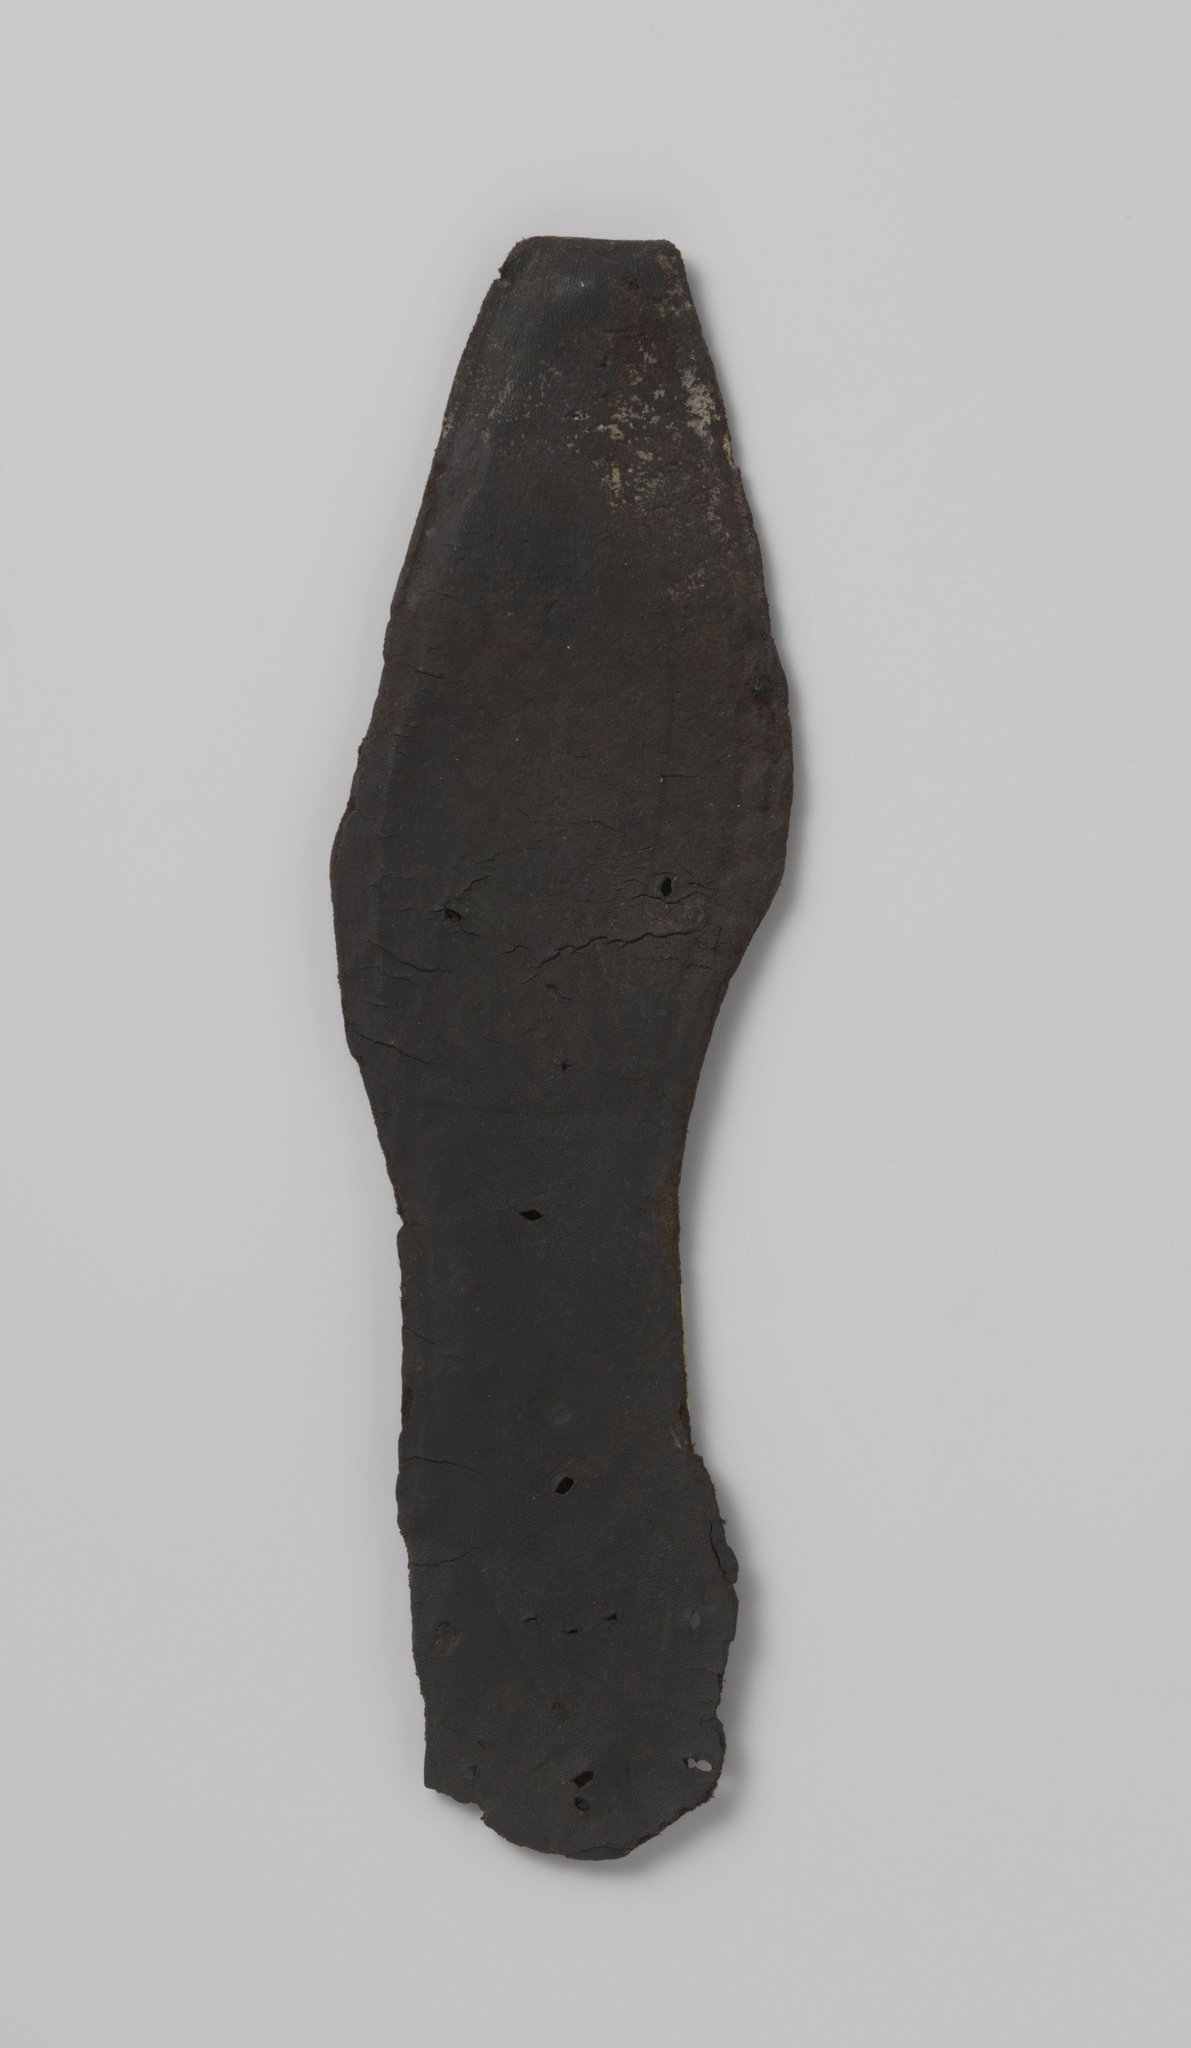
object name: sole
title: Schoenzool uit V.O.C.-schip de 'Witte Leeuw'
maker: Anonymous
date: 1613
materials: leather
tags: verenigde oostindische compagnie, sint-helena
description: Schoenzool uit V.O.C.-schip de 'Witte Leeuw'.